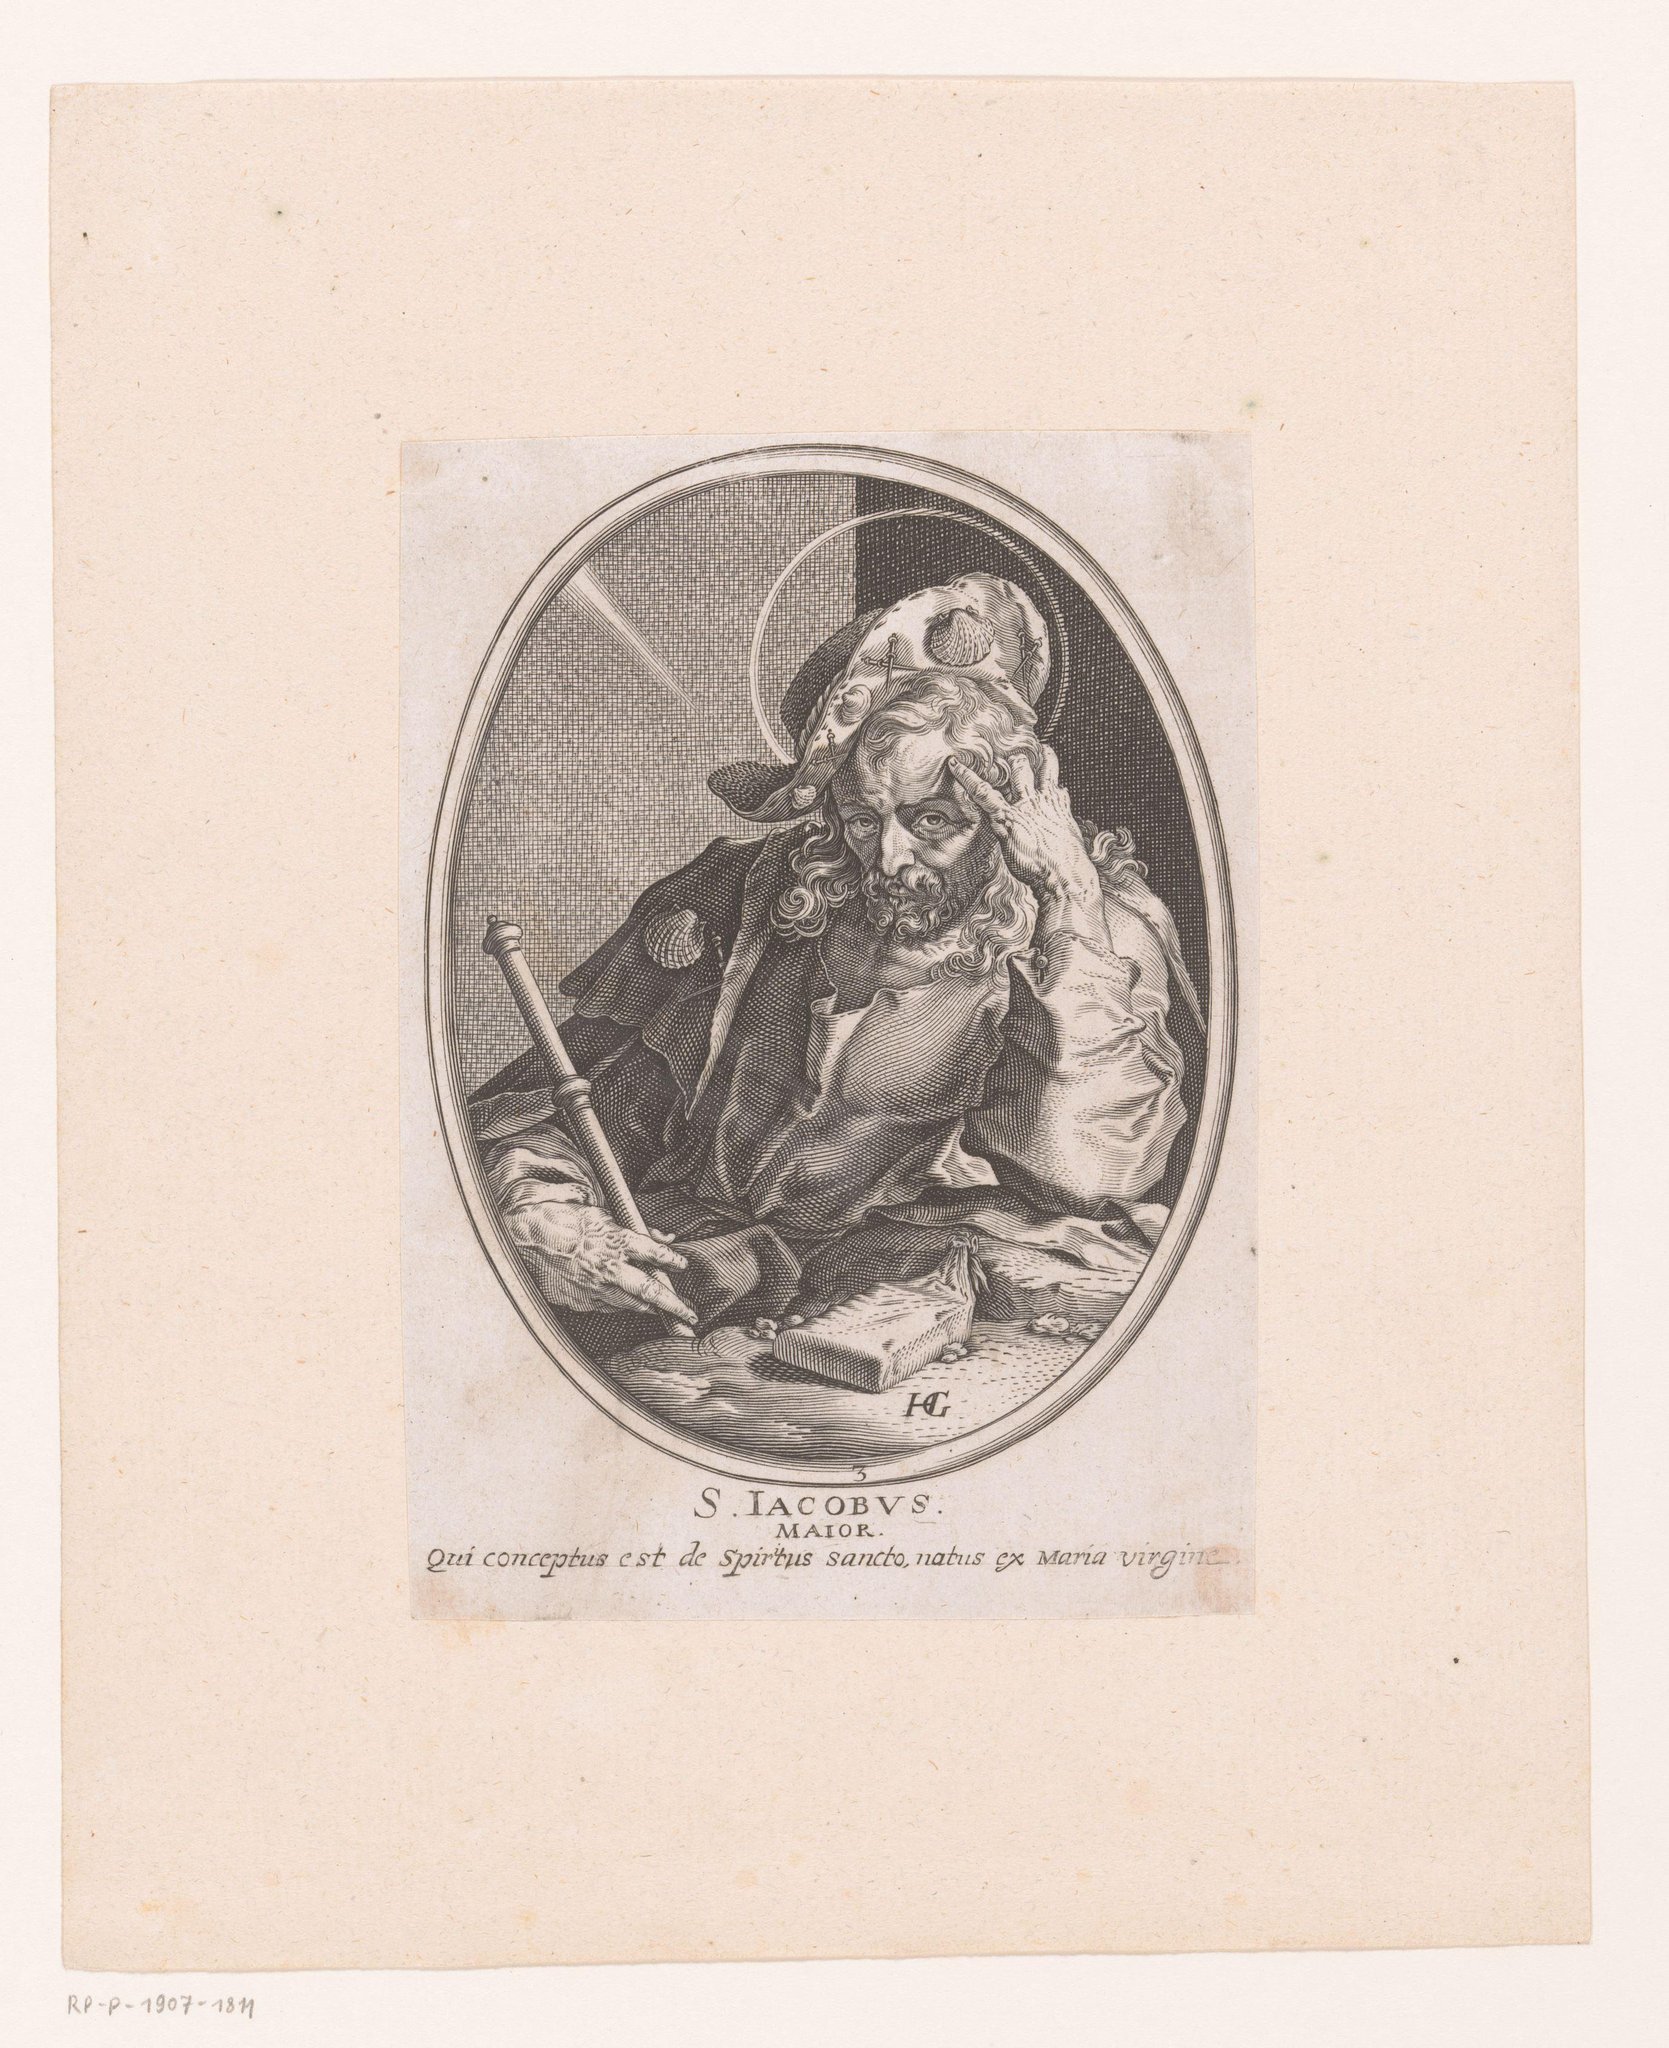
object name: print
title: Apostelen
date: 1610-1668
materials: paper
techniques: engraving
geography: paris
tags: life and acts of james the great (the elder)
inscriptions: collector's mark: Lugt 2228